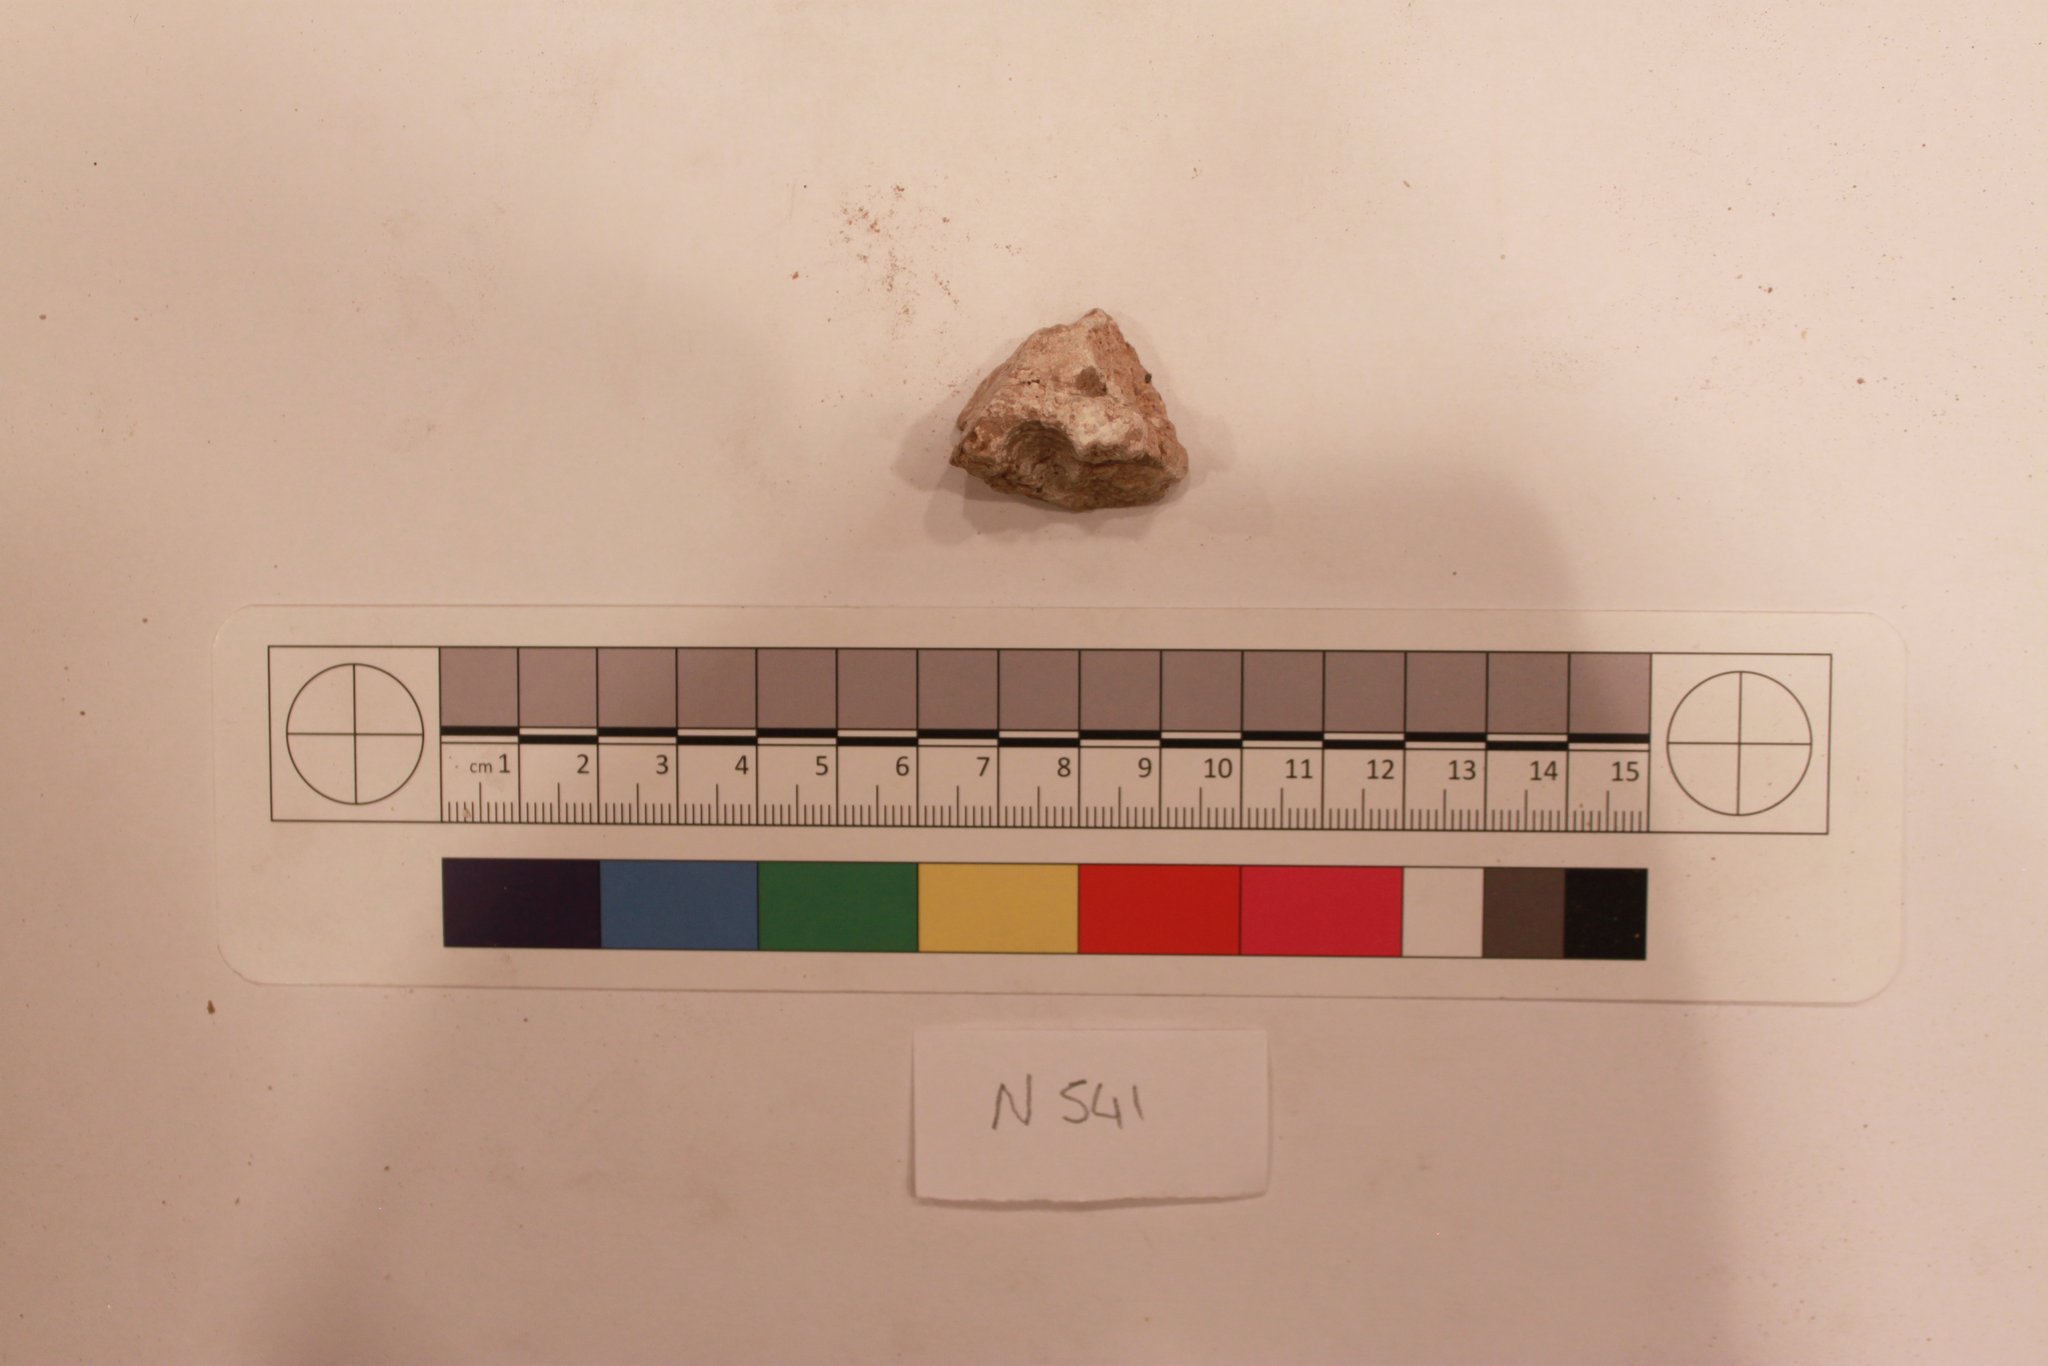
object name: fragment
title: Stucco Fragment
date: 701-1200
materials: plaster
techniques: carving, painting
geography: iran